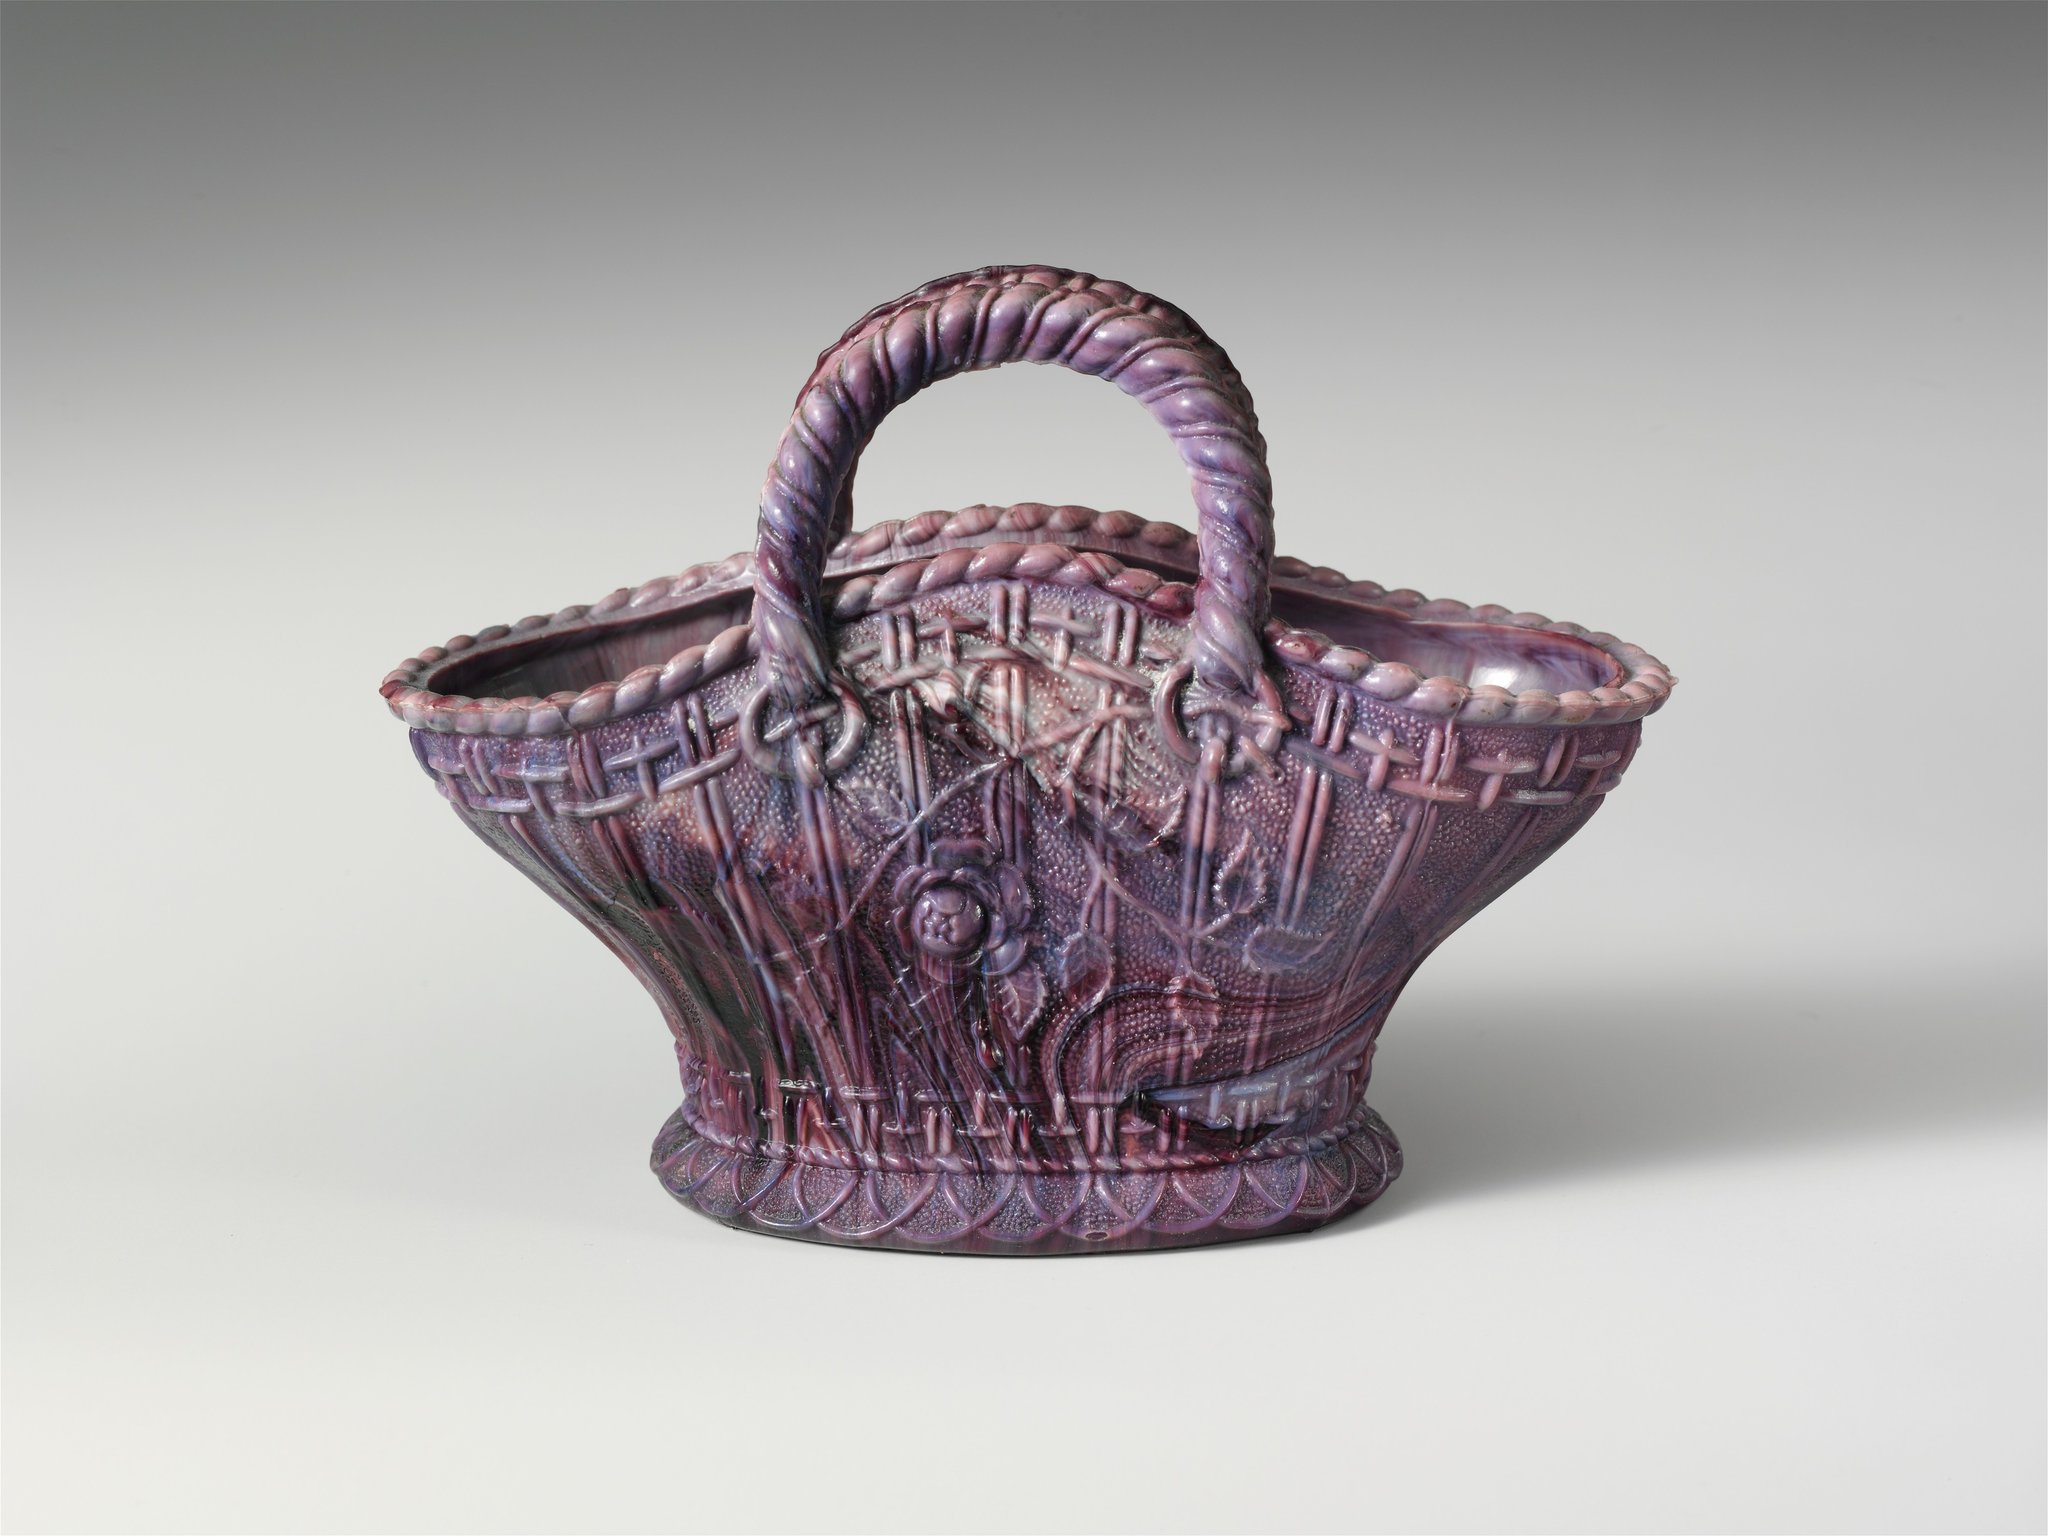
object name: basket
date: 1880-1890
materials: glass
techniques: pressed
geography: england